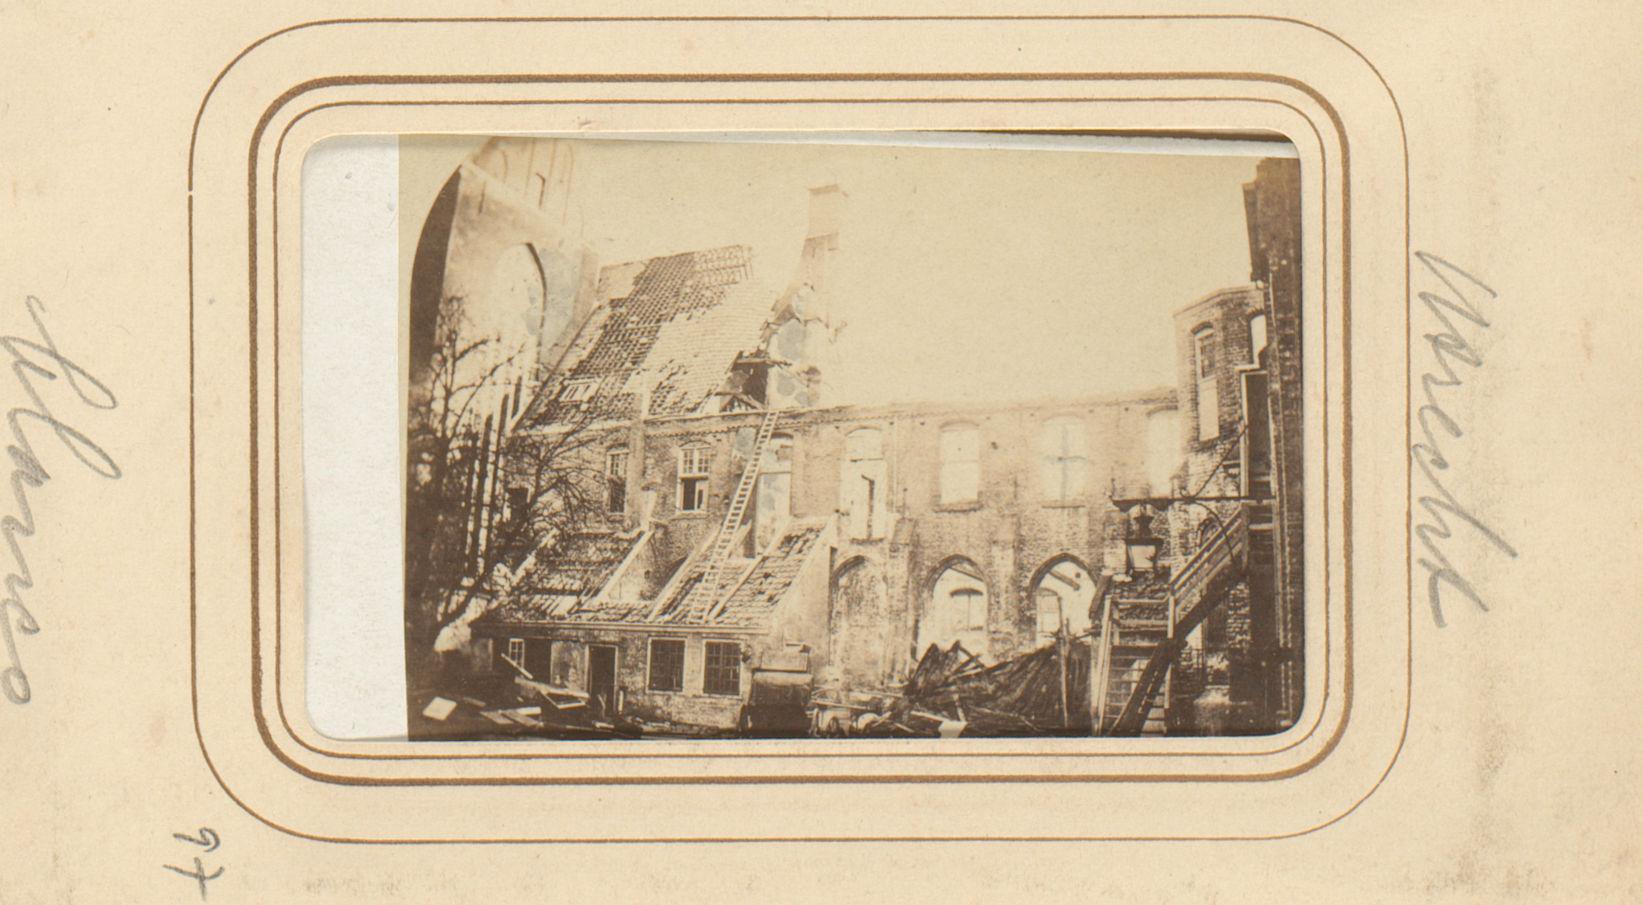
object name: album leaf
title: Catharijneconvent te Utrecht na de brand van 1868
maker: willem cornelis van dijk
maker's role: painter, print maker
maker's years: 1826-1881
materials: cardboard, photographic support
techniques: albumen print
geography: utrecht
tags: ruin of a building ~ architecture, church (exterior), utrecht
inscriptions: signature: ‘W.C. VAN DIJK / PHOTOGRAPHE / UTRECHT’, inscription: ‘W.C. VAN DIJK / PHOTOGRAPHE / UTRECHT / Langenieuwstraat / Lett. A, No. 522’